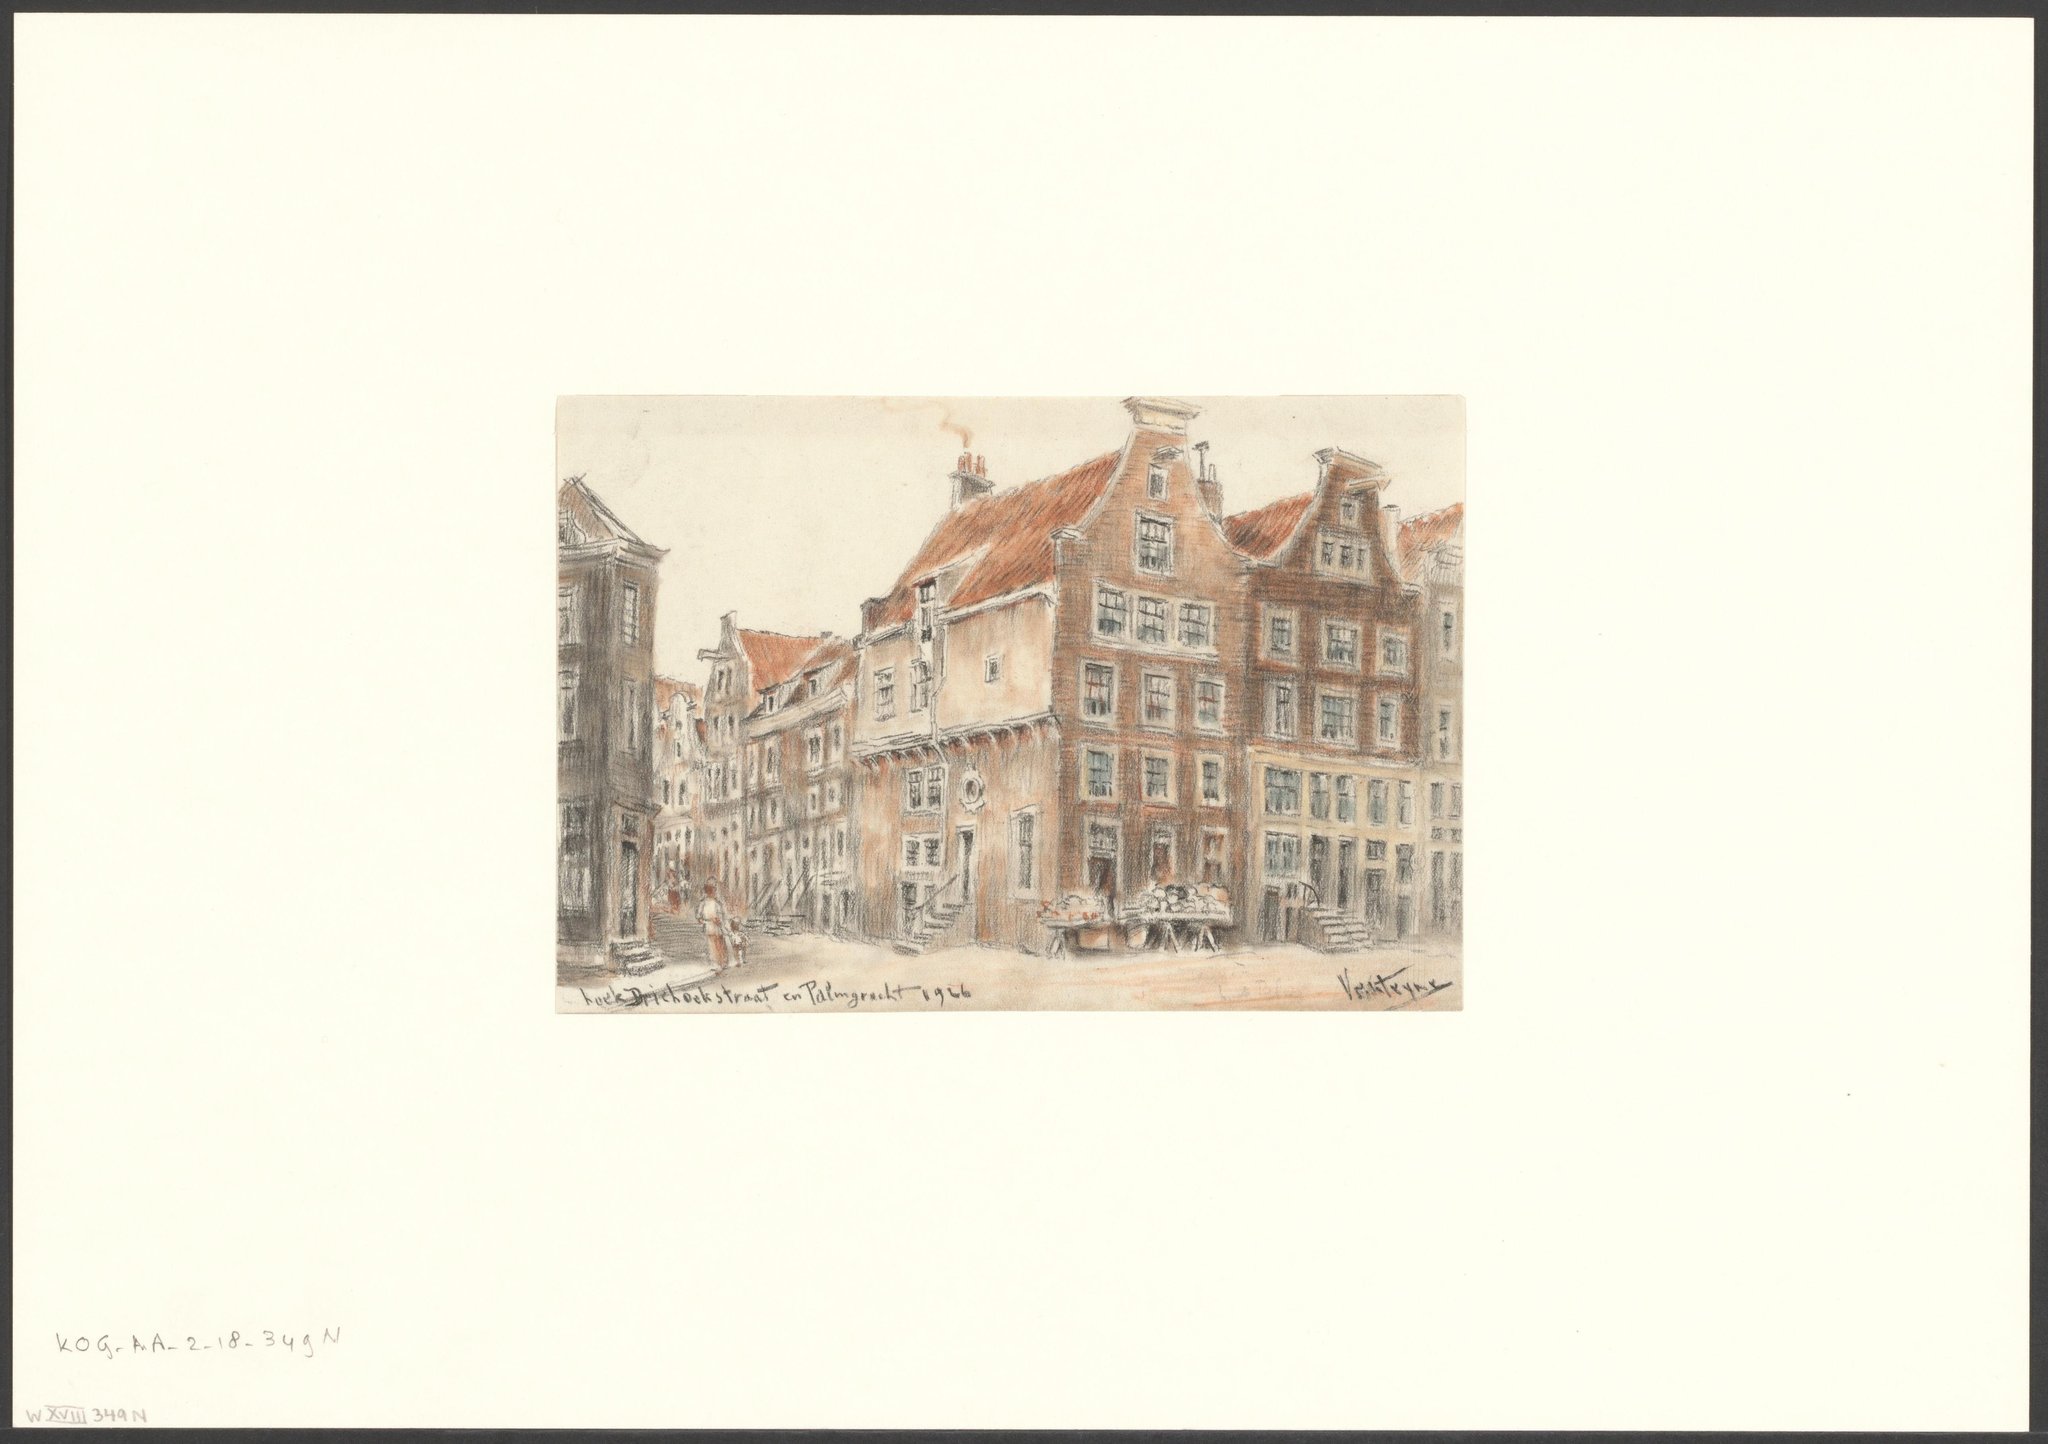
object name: drawing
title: Gezicht op de Driehoekstraat en de Palmgracht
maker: anthonie van teijn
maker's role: draughtsman, painter, print maker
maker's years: 1863-1943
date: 1926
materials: chalk, paper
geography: amsterdam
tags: city-view in general; 'veduta', façade (of house or building), street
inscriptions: inscription: ‘hoek Driehoekstraat en Palmgracht 1926’, stamp: ‘J. van Eck.’, signature: ‘VanTeyne’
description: Tekening binnen de Atlas Van Eck ingedeeld op wijknummer 18.